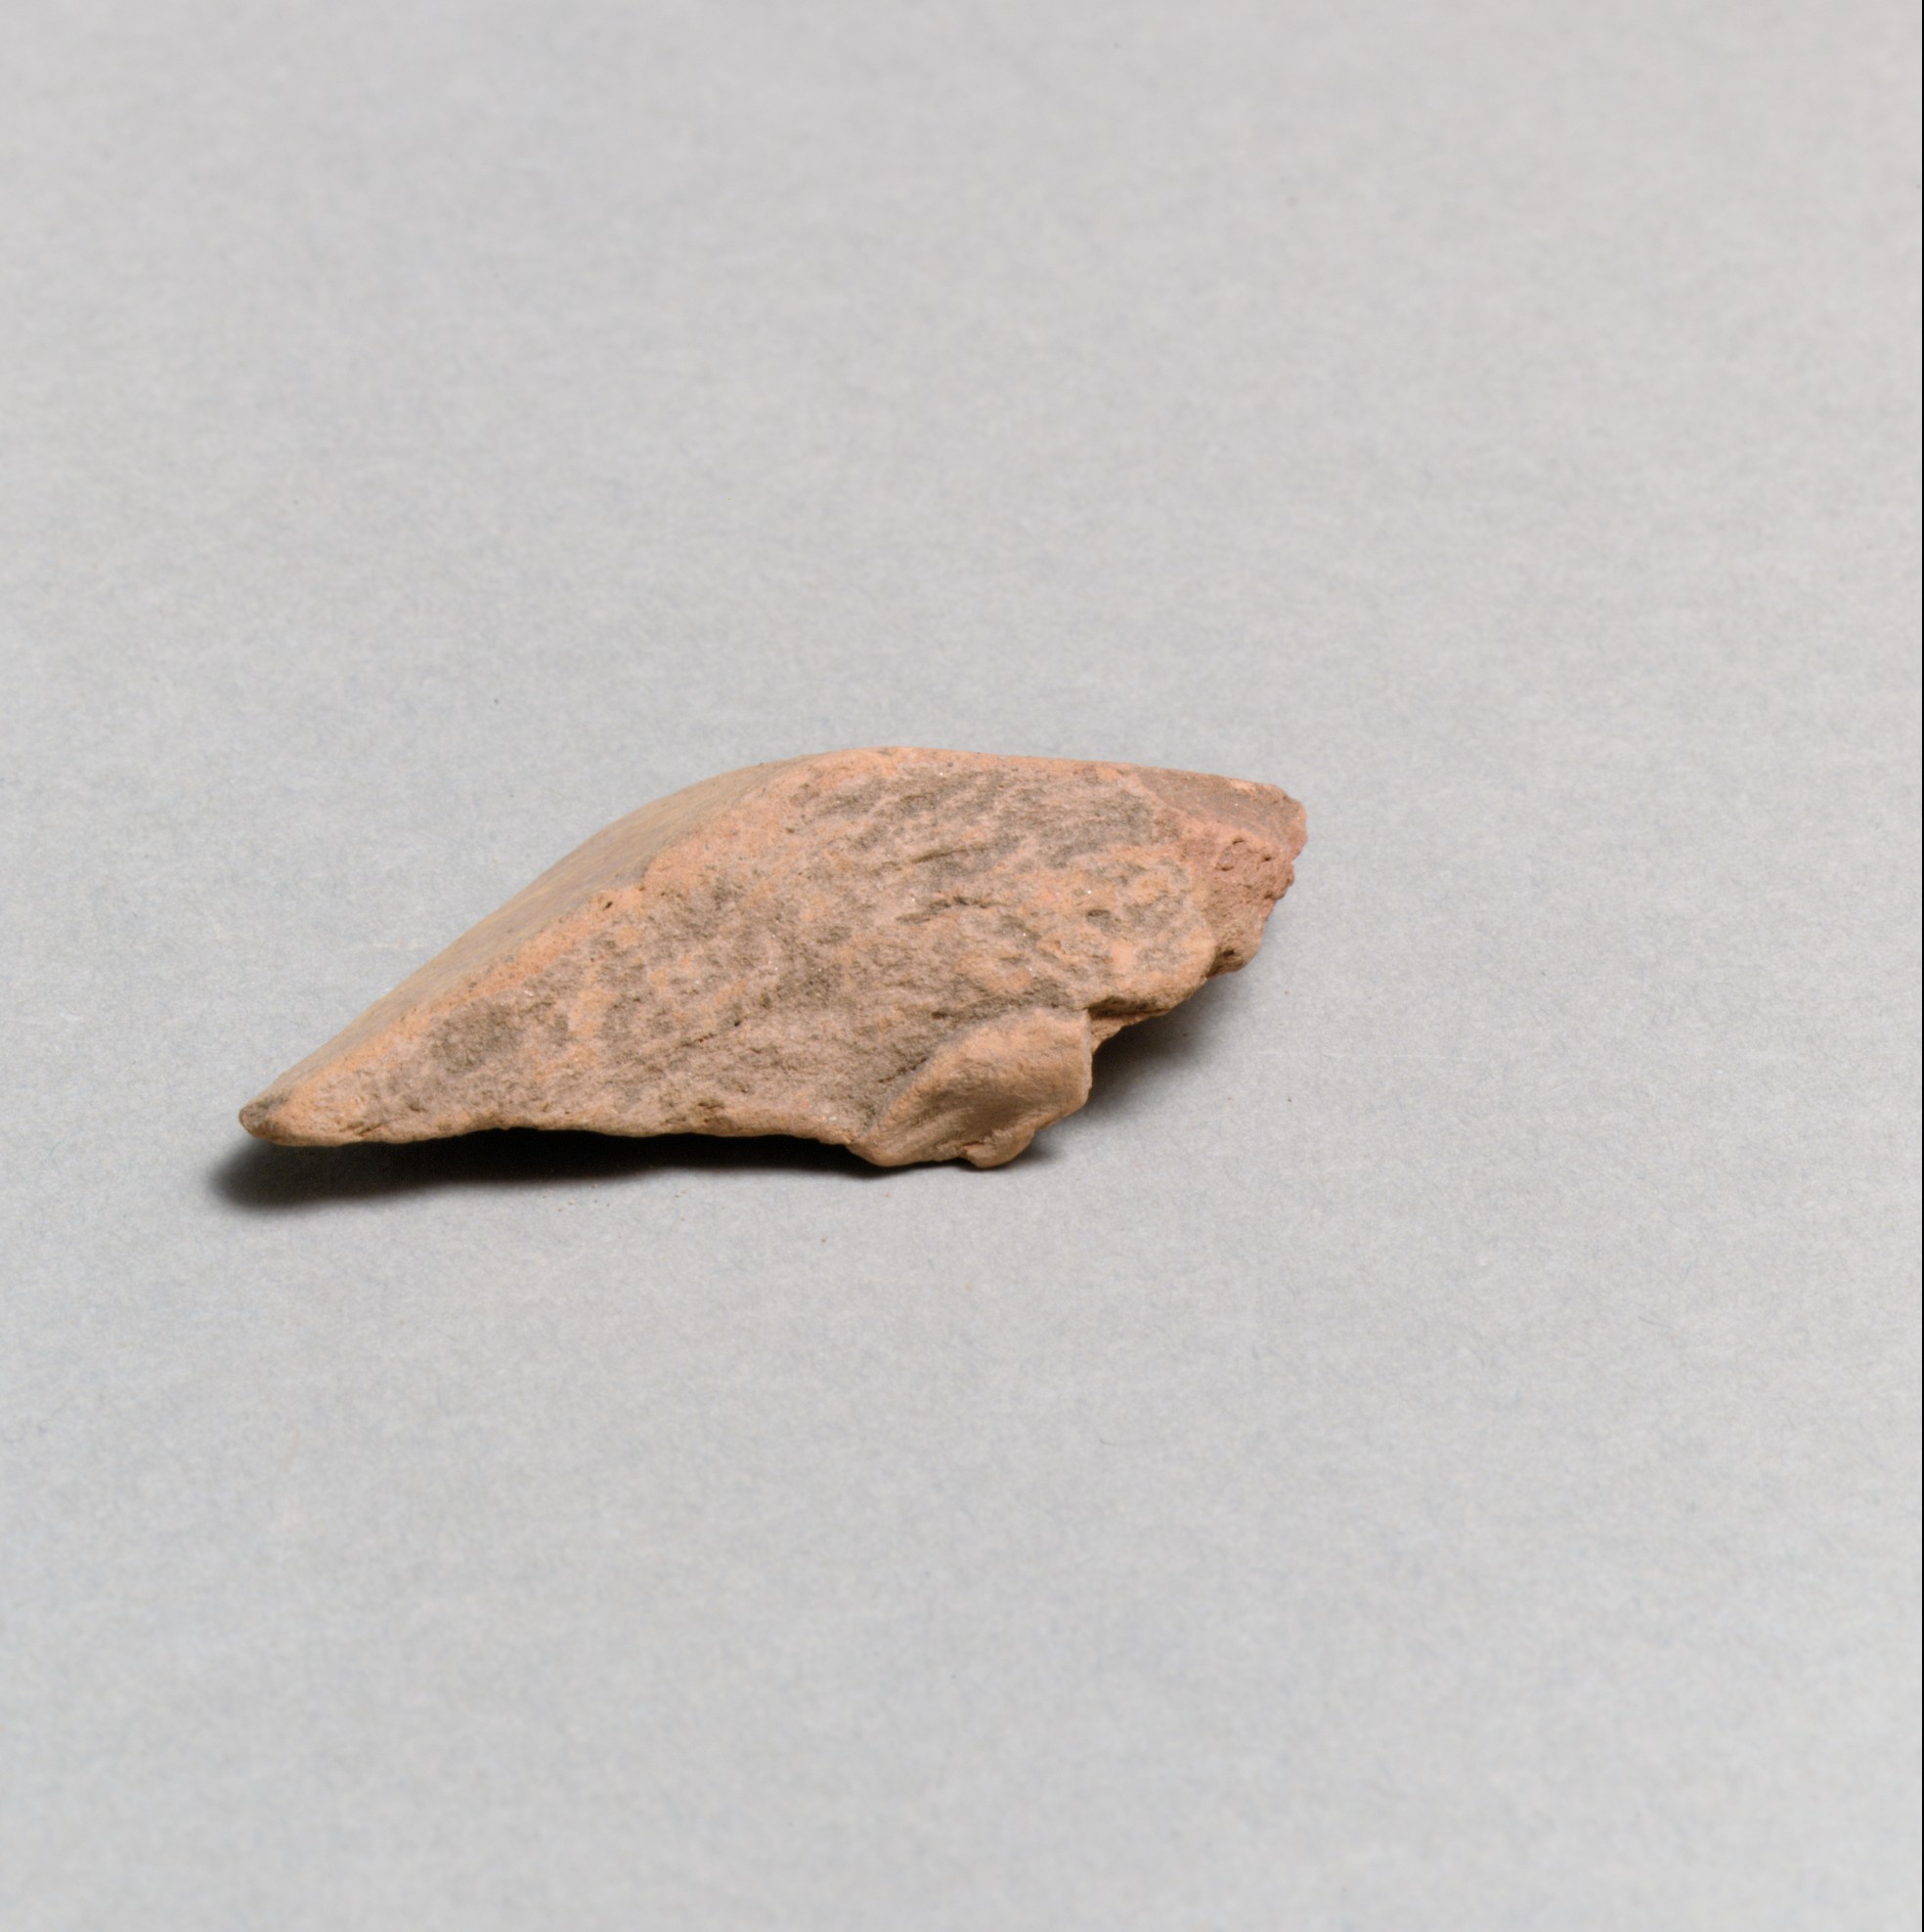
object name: vase fragment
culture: greek, lydian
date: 7000-30 BCE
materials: terracotta